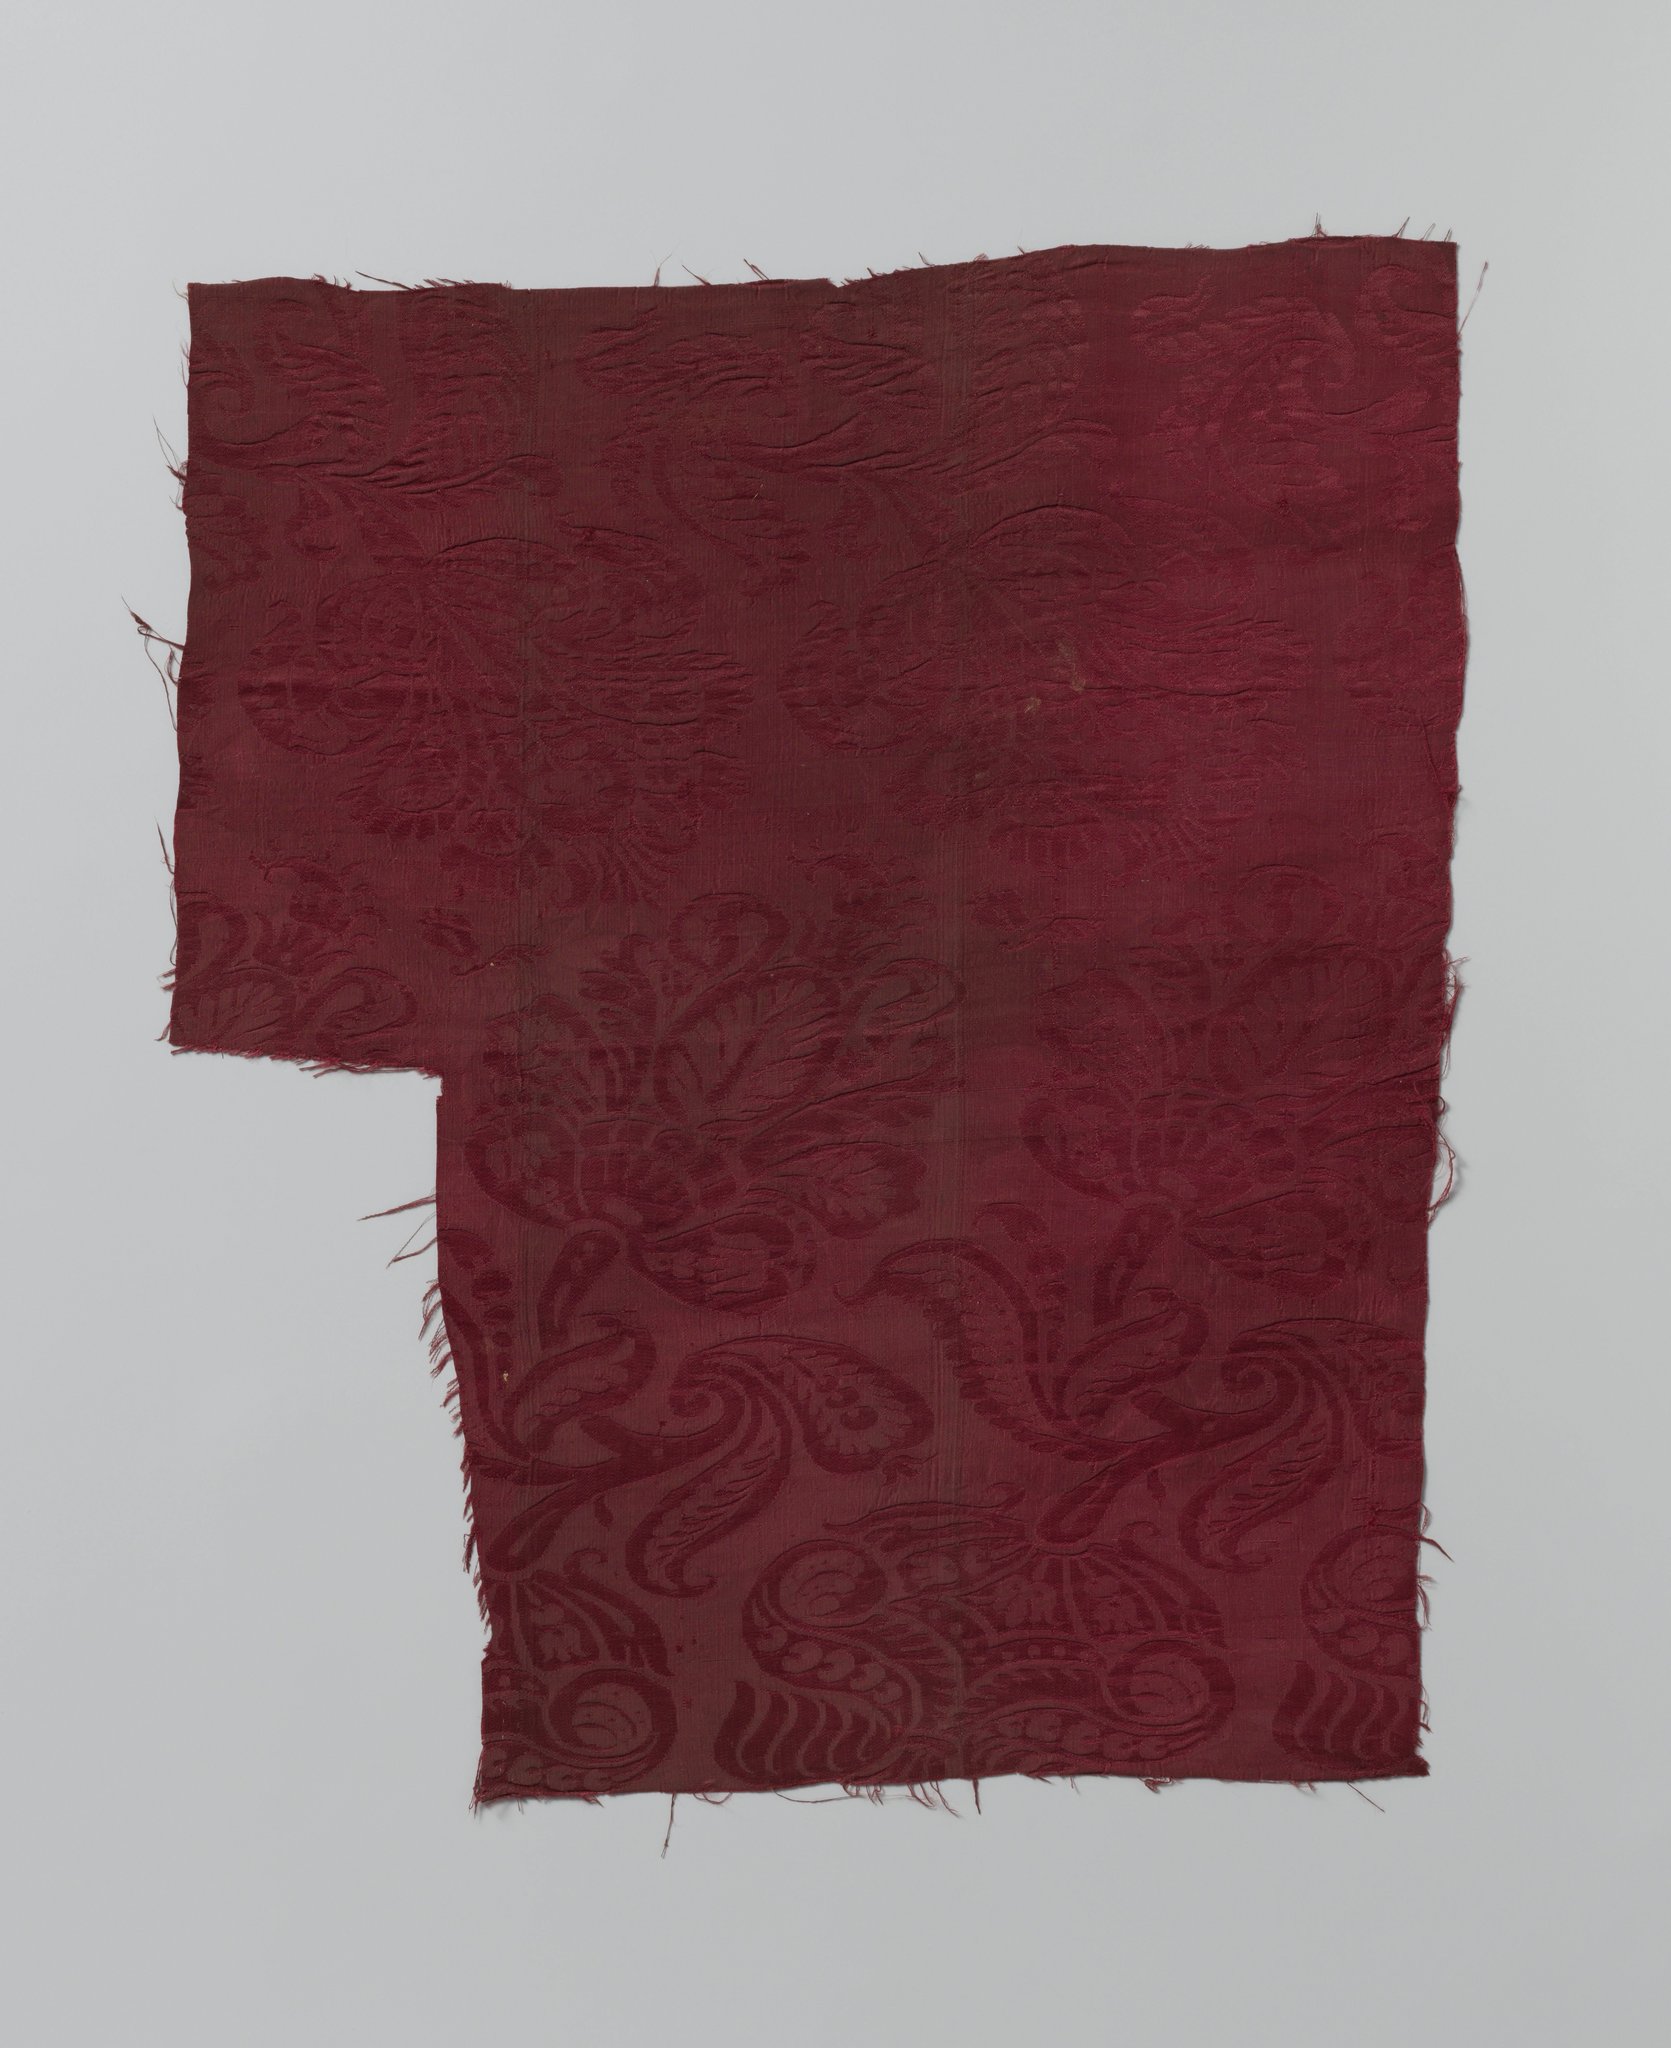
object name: zijdedamast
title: Fragment rood zijdedamast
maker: Anonymous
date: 1600-1699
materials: silk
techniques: damask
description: Twee fragmenten rood zijdeweefsel met een patroon van gestileerde bloemmotieven.